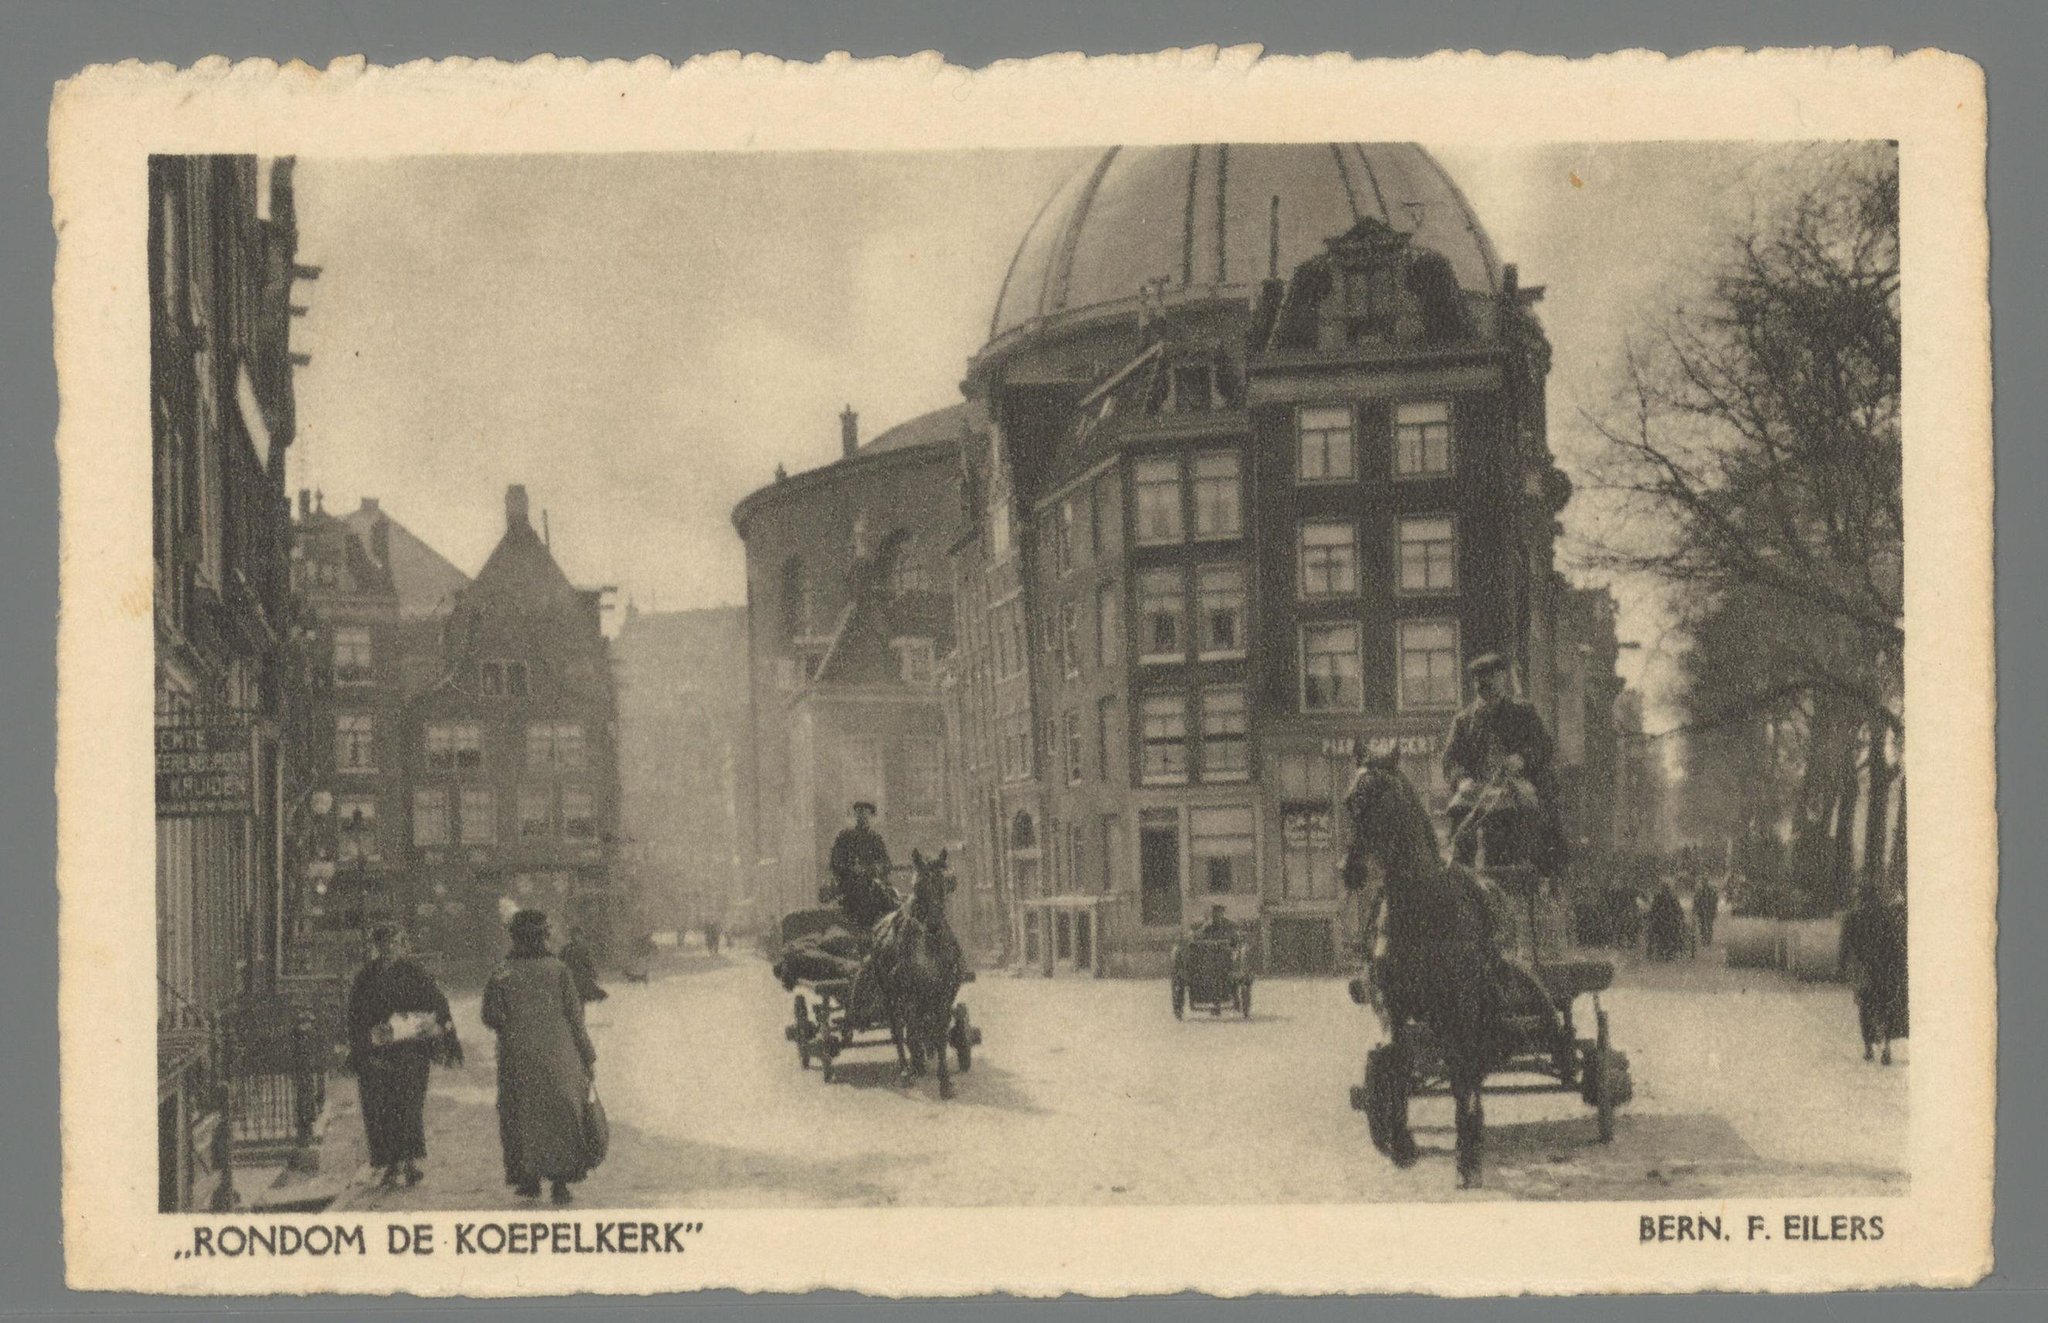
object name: photomechanical print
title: Eilers' artistieke series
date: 1928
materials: cardboard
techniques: photograph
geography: amsterdam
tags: animal traction, animal-drawn vehicle (carriage etc.), city-view, and landscape with man-made constructions, church (exterior), street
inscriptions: inscription: ‘AMSTERDAM - STROOMARKT EN KATTEGAT / Naam / Adres / EILERS' ARTISTIEKE SERIES’, inscription: ‘"RONDOM DE KOEPELKERK" BERN. F. EILERS’